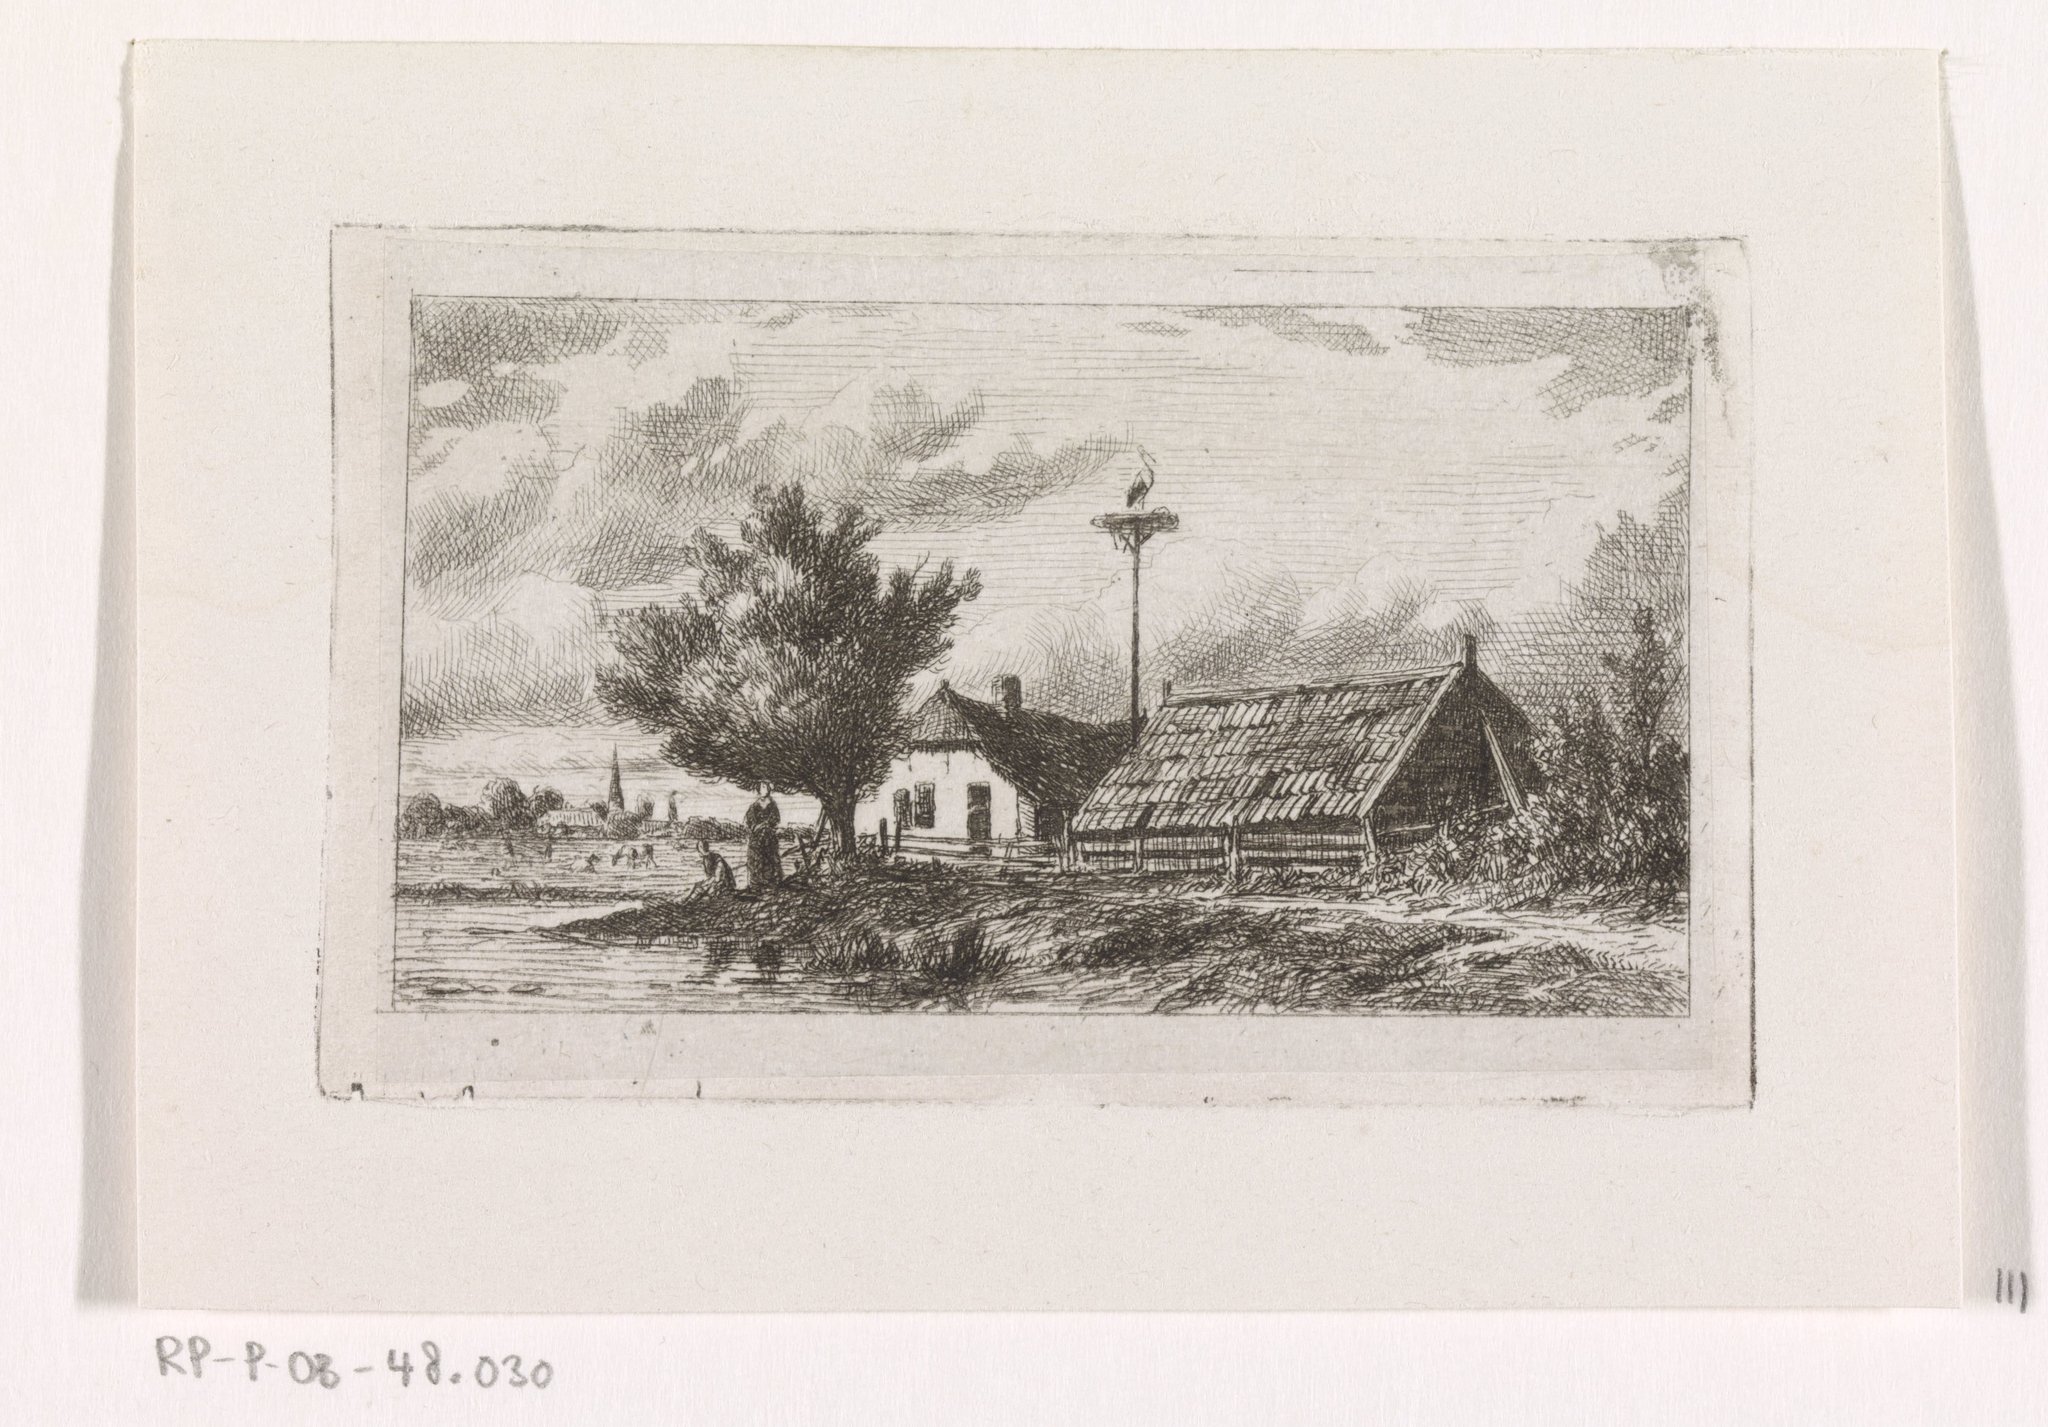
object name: print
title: Ooievaarsnest tussen huizen aan de waterkant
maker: jacob jan van der maaten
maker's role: draughtsman, print maker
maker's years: 1820-1879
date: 1830-1879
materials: paper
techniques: etching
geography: netherlands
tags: shore-birds and wading-birds: stork (+ nest, den, burrow), water course (+ landscape with figures, staffage), farm or solitary house in landscape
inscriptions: collector's mark: Lugt 2228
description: Een ooievaarsnest tussen een schuur en een woning aan een waterkant. Links op de voorgrond een man en een vrouw onder een boom.